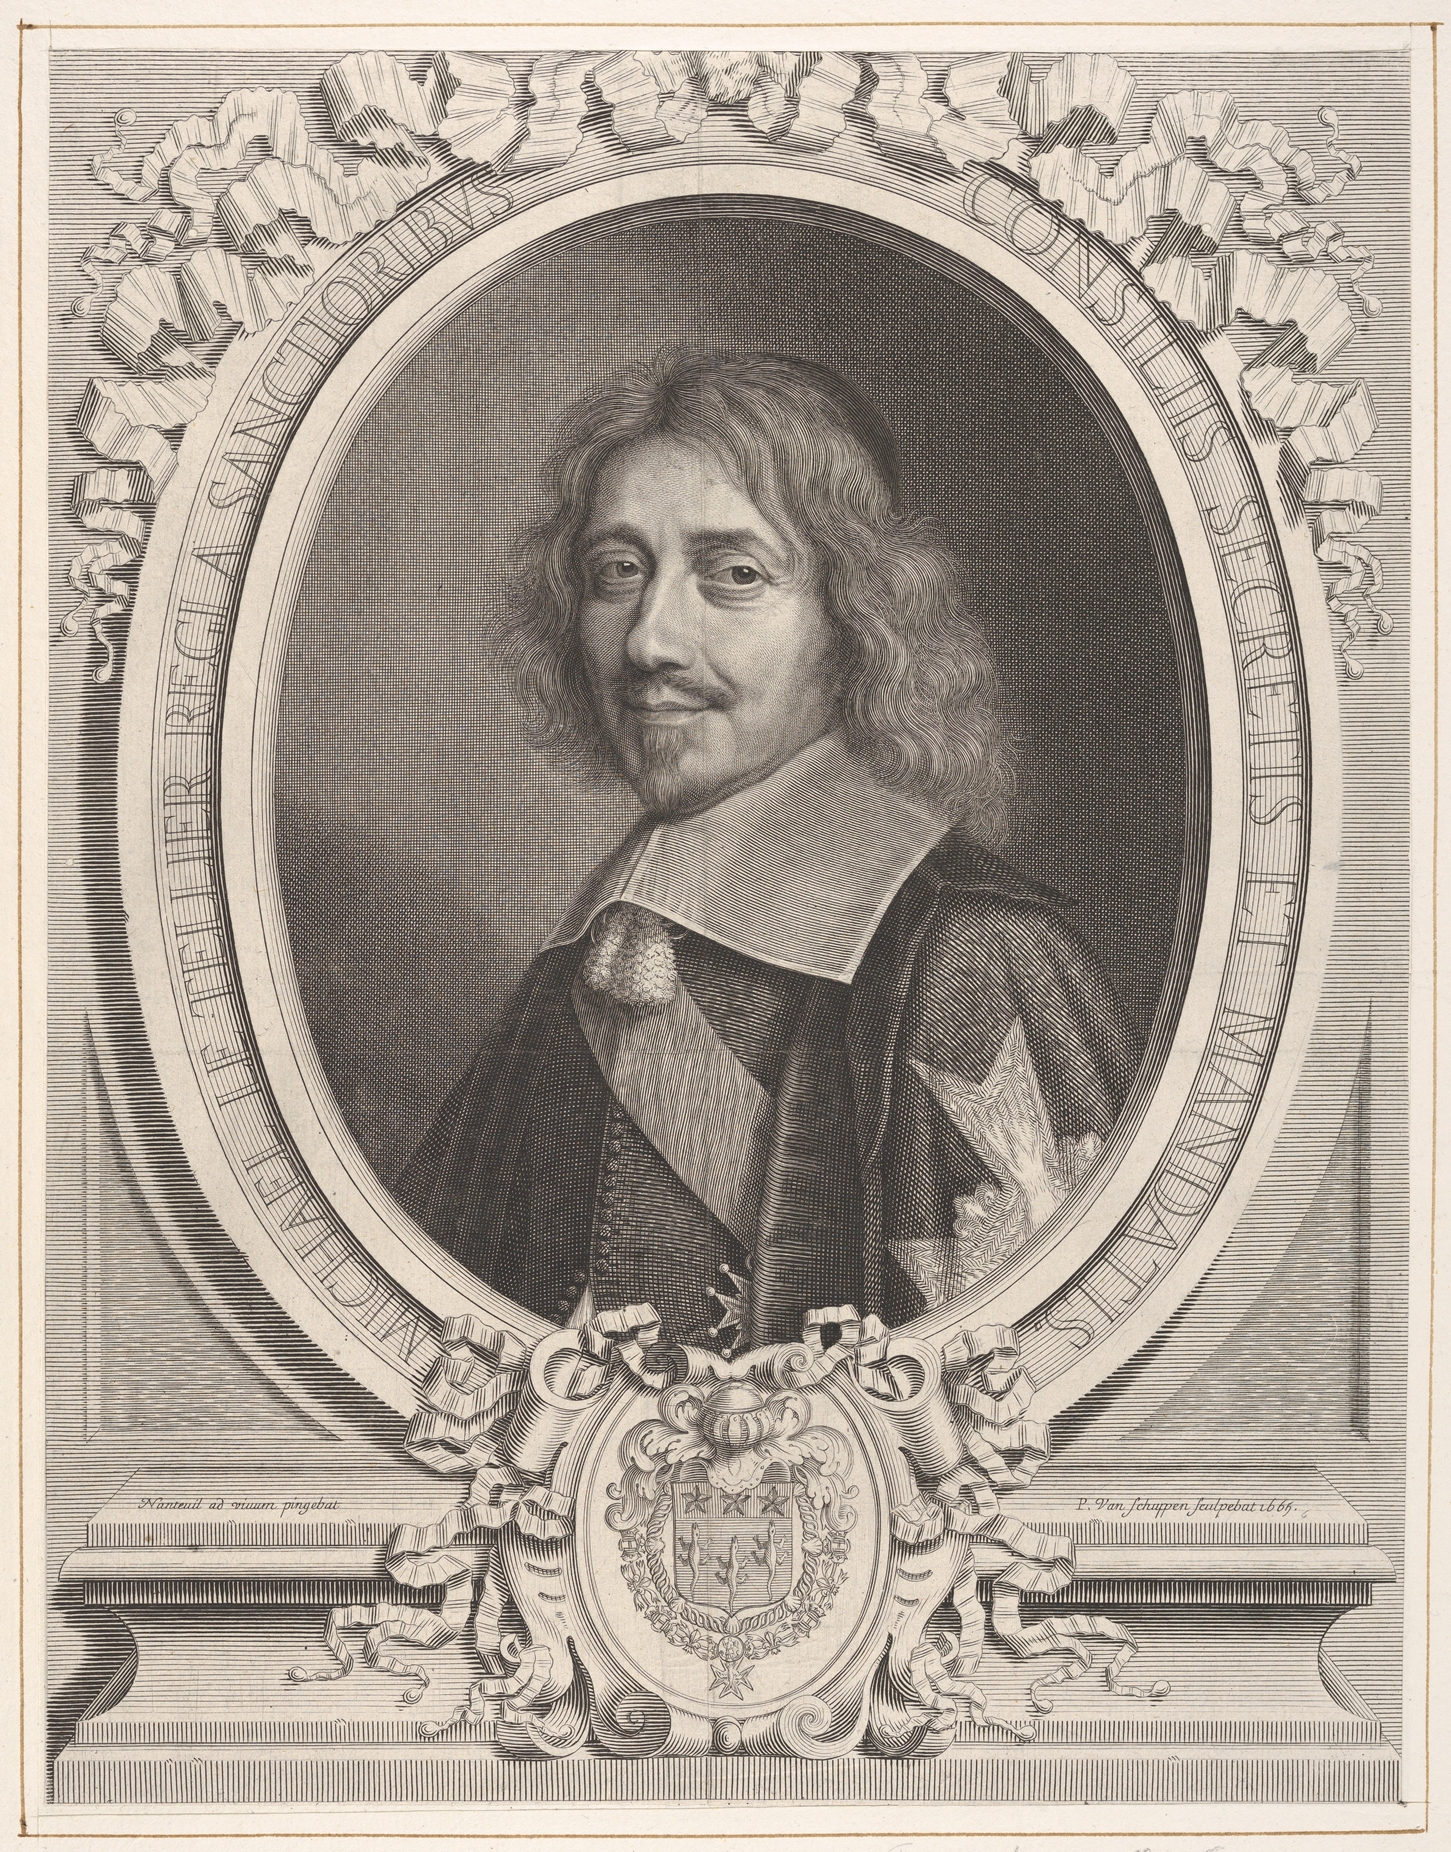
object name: print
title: Michael IV Le Tellier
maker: pieter van schuppen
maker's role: artist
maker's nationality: flemish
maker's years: 1627-1702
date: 1601-1700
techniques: engraving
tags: men,portraits,coat of arms